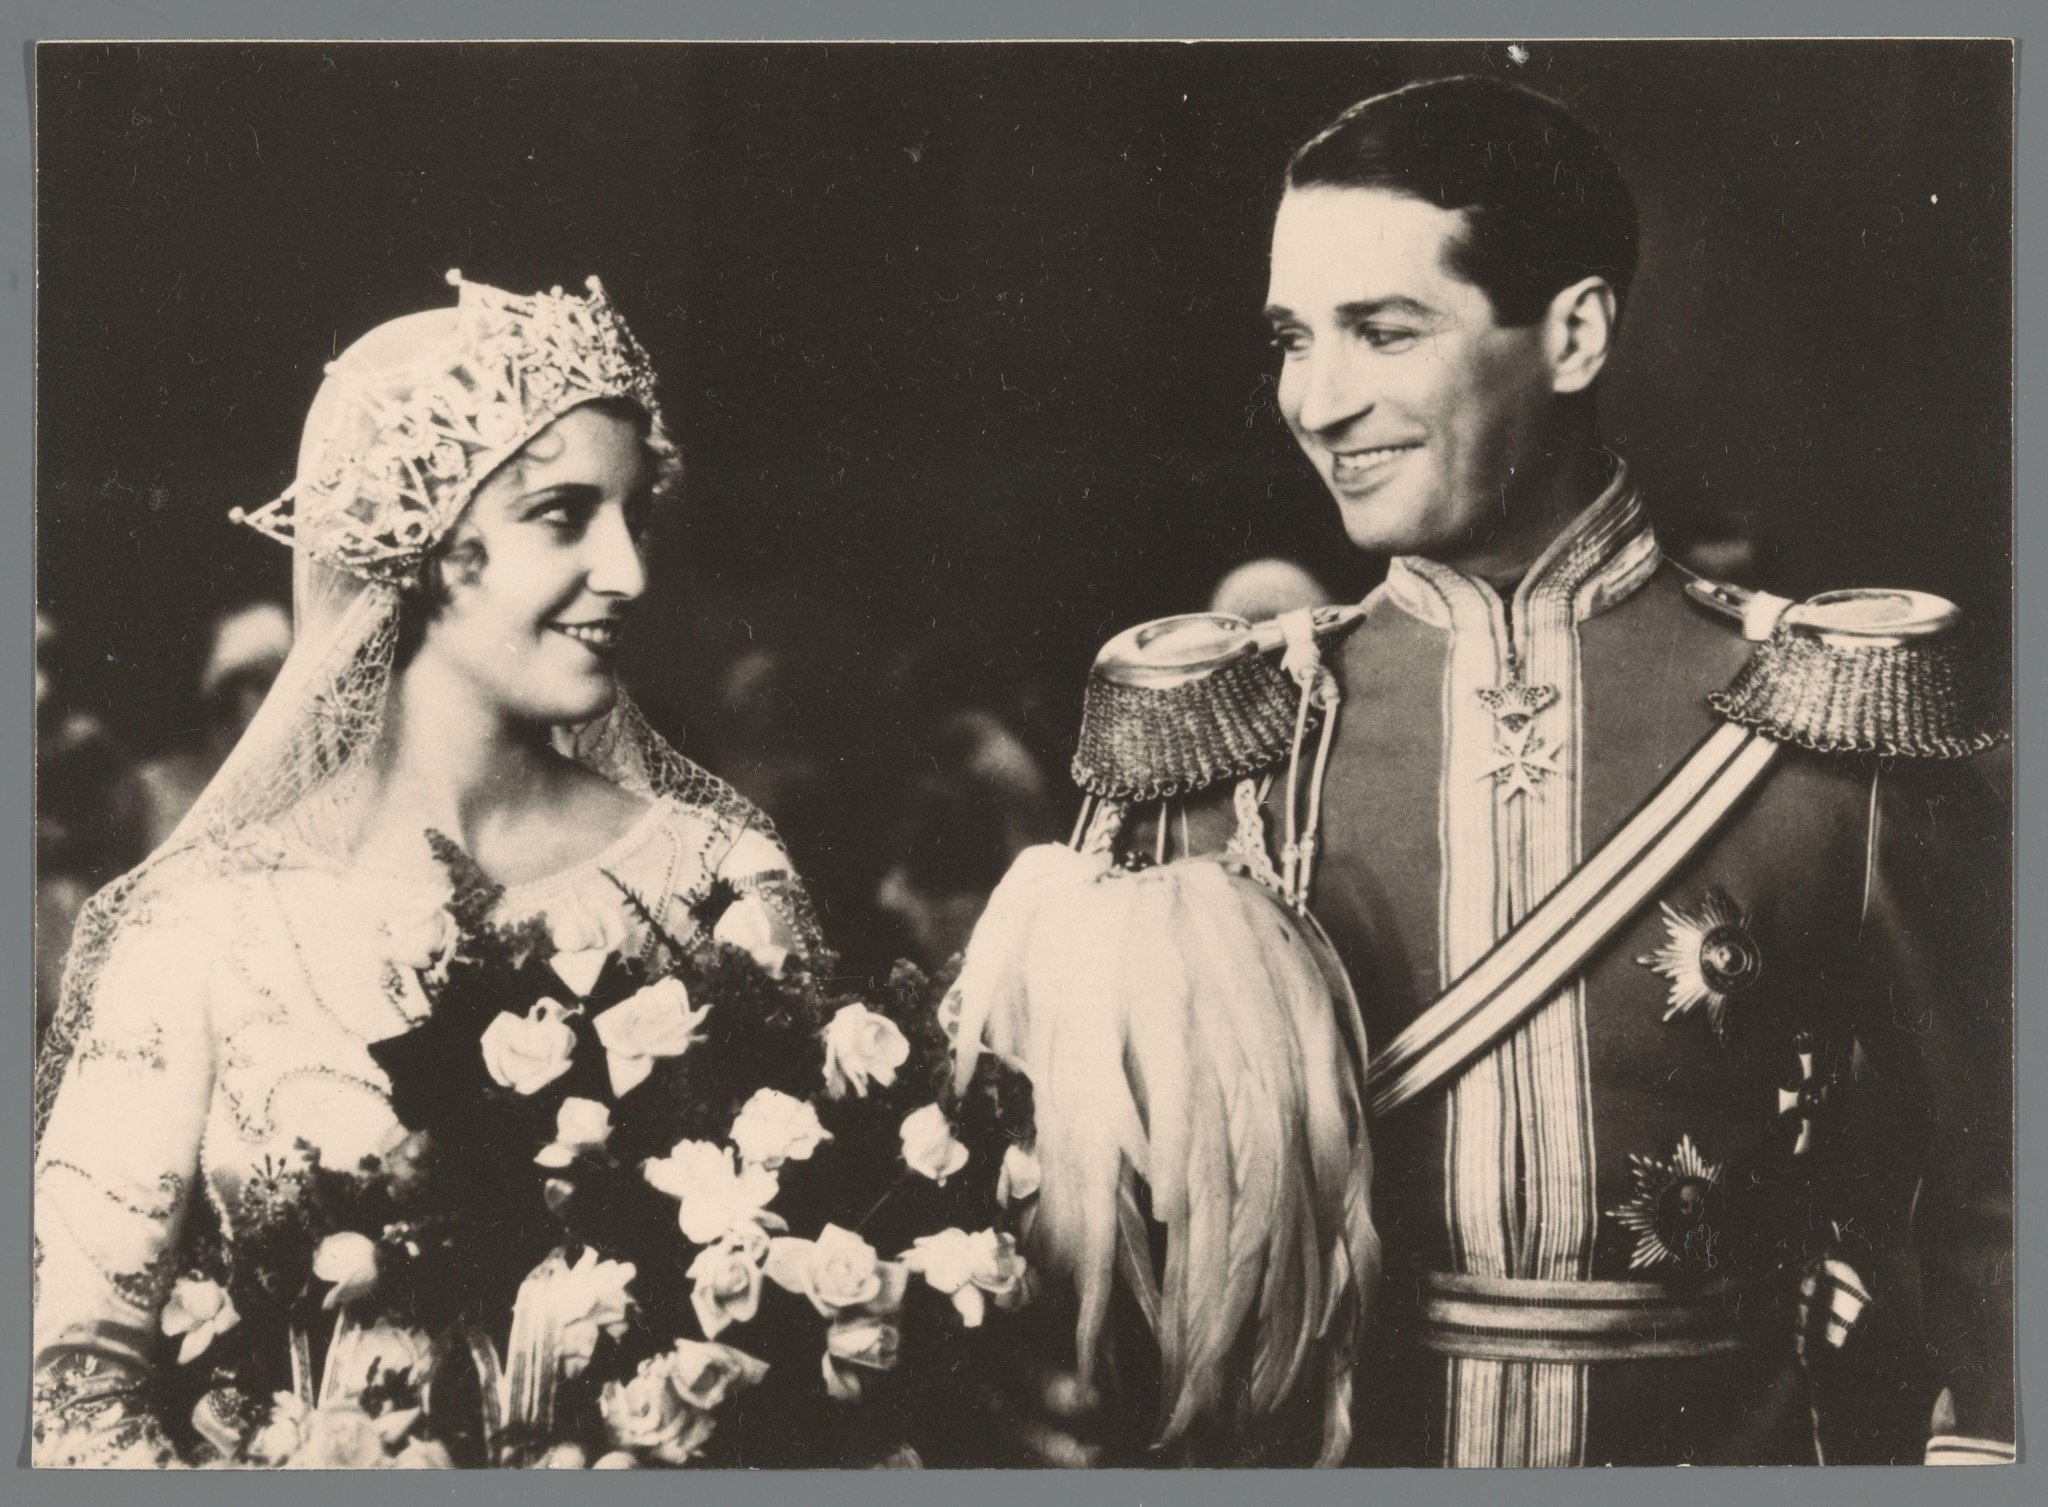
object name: photograph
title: The Love Parade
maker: Anonymous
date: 1929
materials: paper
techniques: gelatin silver print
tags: film actor (on the screen)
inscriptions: stamp: ‘Nederlands Filmmuseum/ Amsterdam’, inscription: ‘The Love Parade/ USA. 1929/ Ernst Lubitsch’